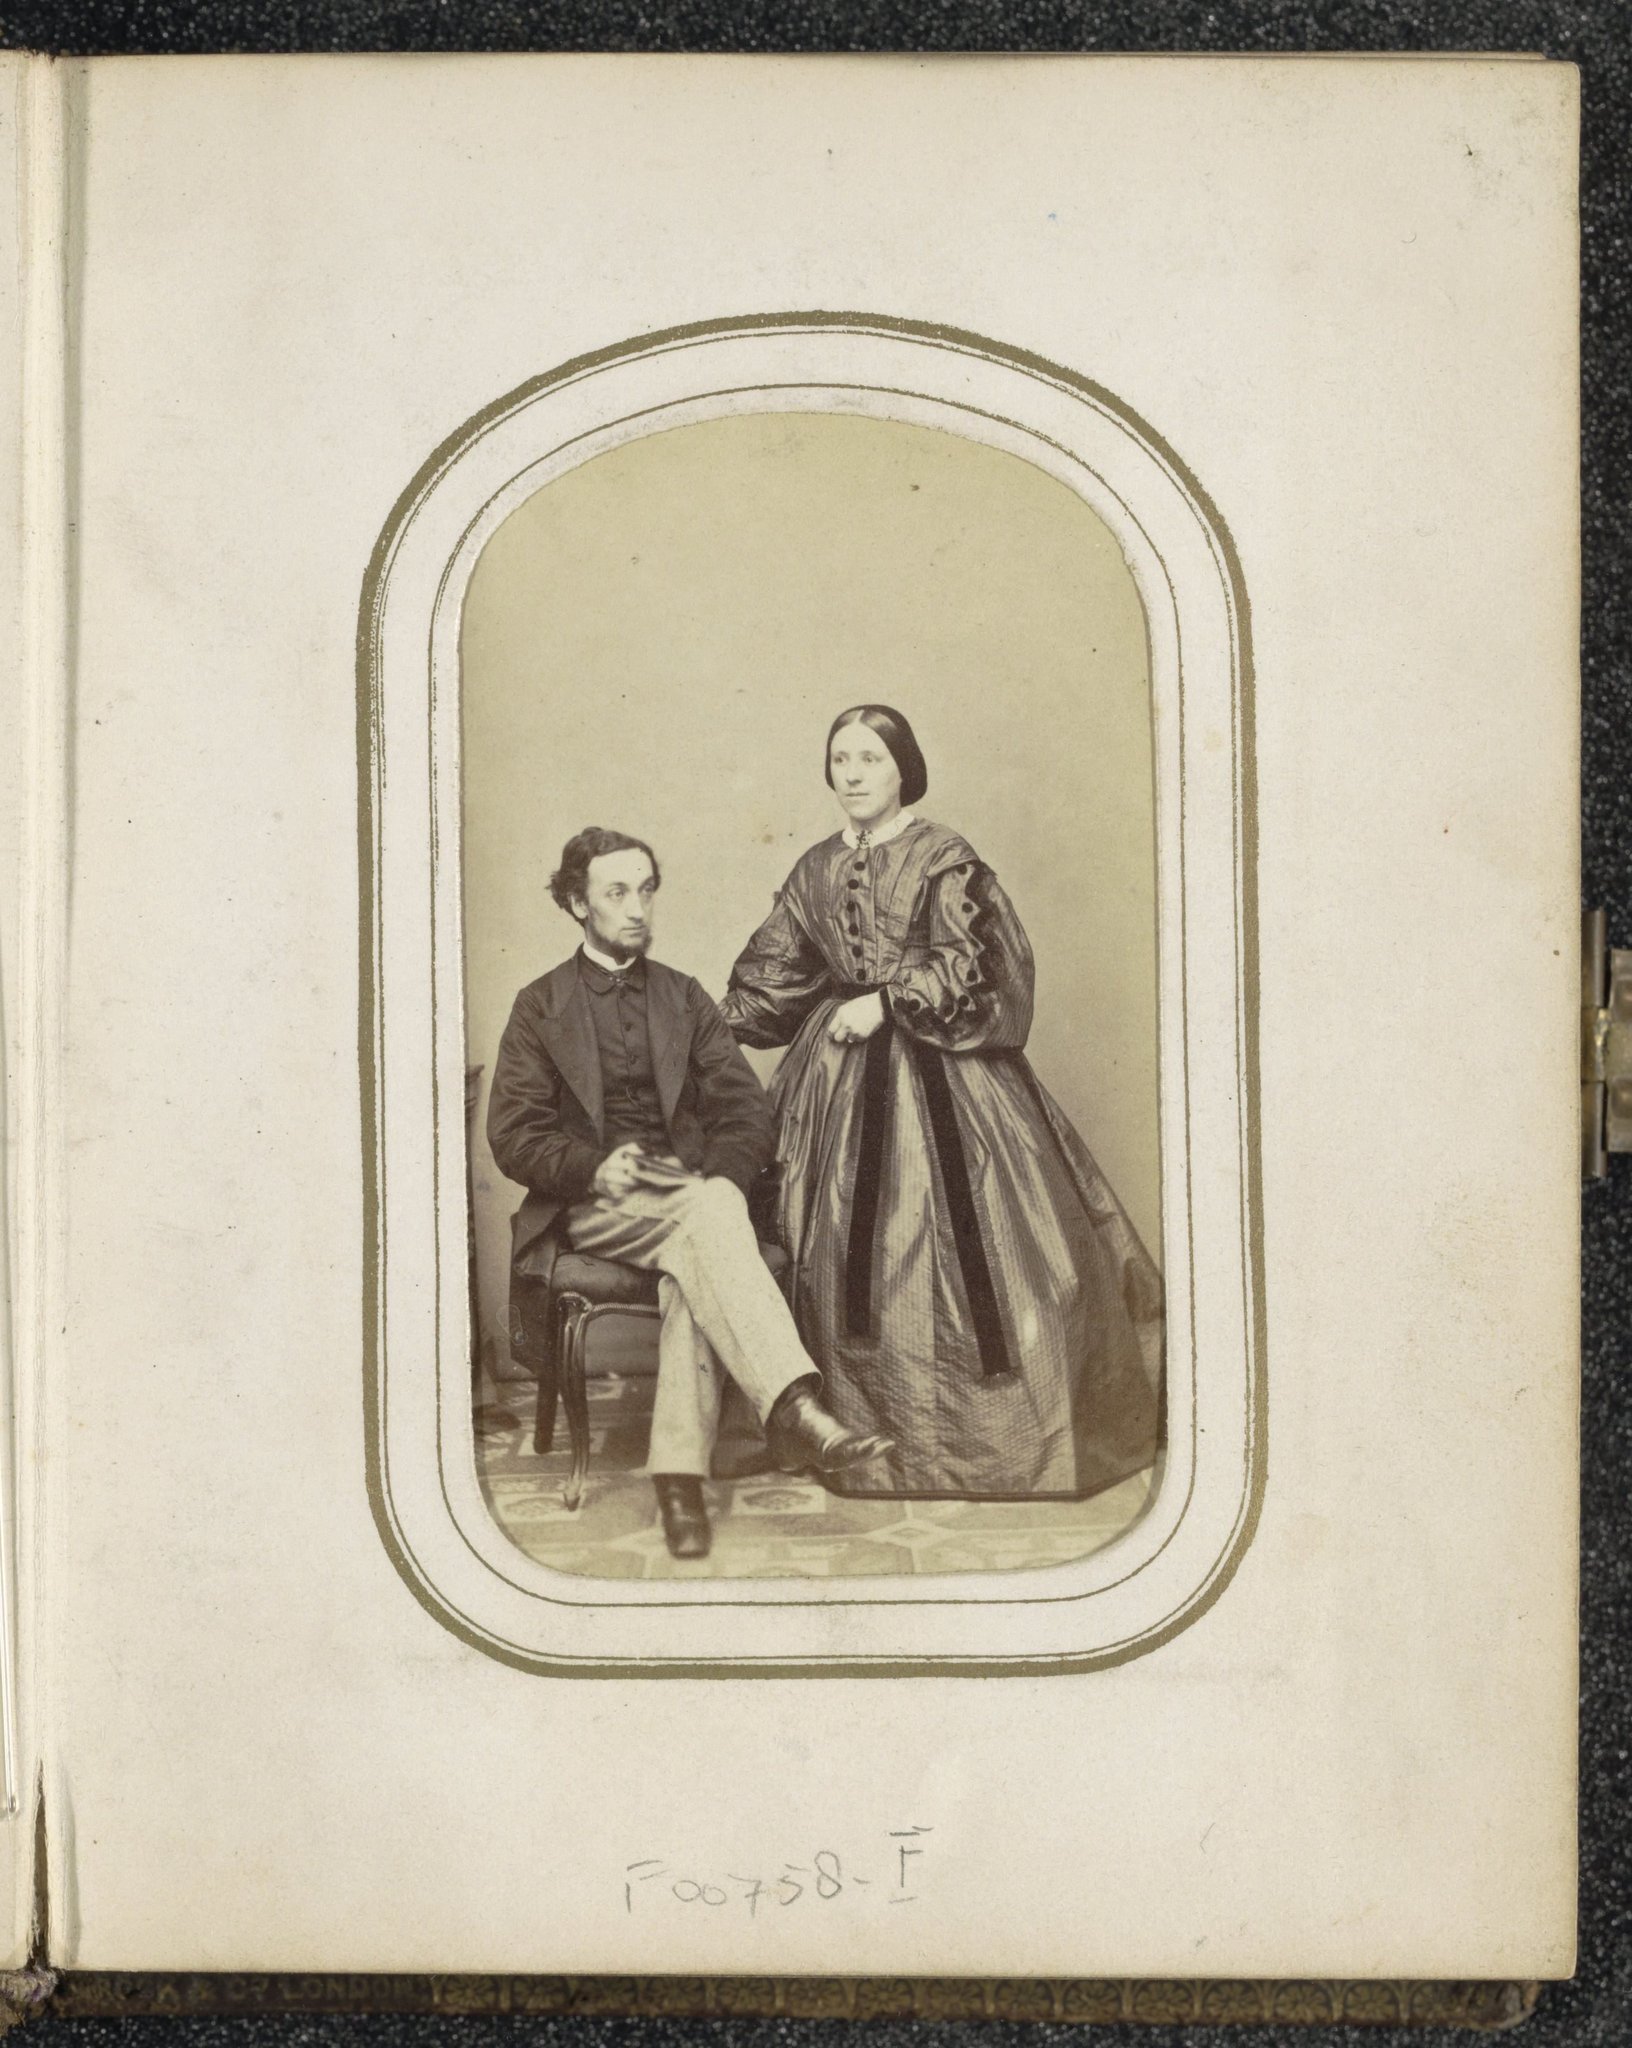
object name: carte de visite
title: Portret van een man en een vrouw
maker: s.j. wiseman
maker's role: fotograaf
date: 1860-1870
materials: cardboard, paper, photographic support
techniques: albumen print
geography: southampton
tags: studio requisites ~ photographer, historical persons, dress, gown, beard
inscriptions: address: ‘Southampton, 9 Bernard St.’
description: Onderdeel van Engels fotoalbum van E.A. Kettle met 42 cartes-de-visite.